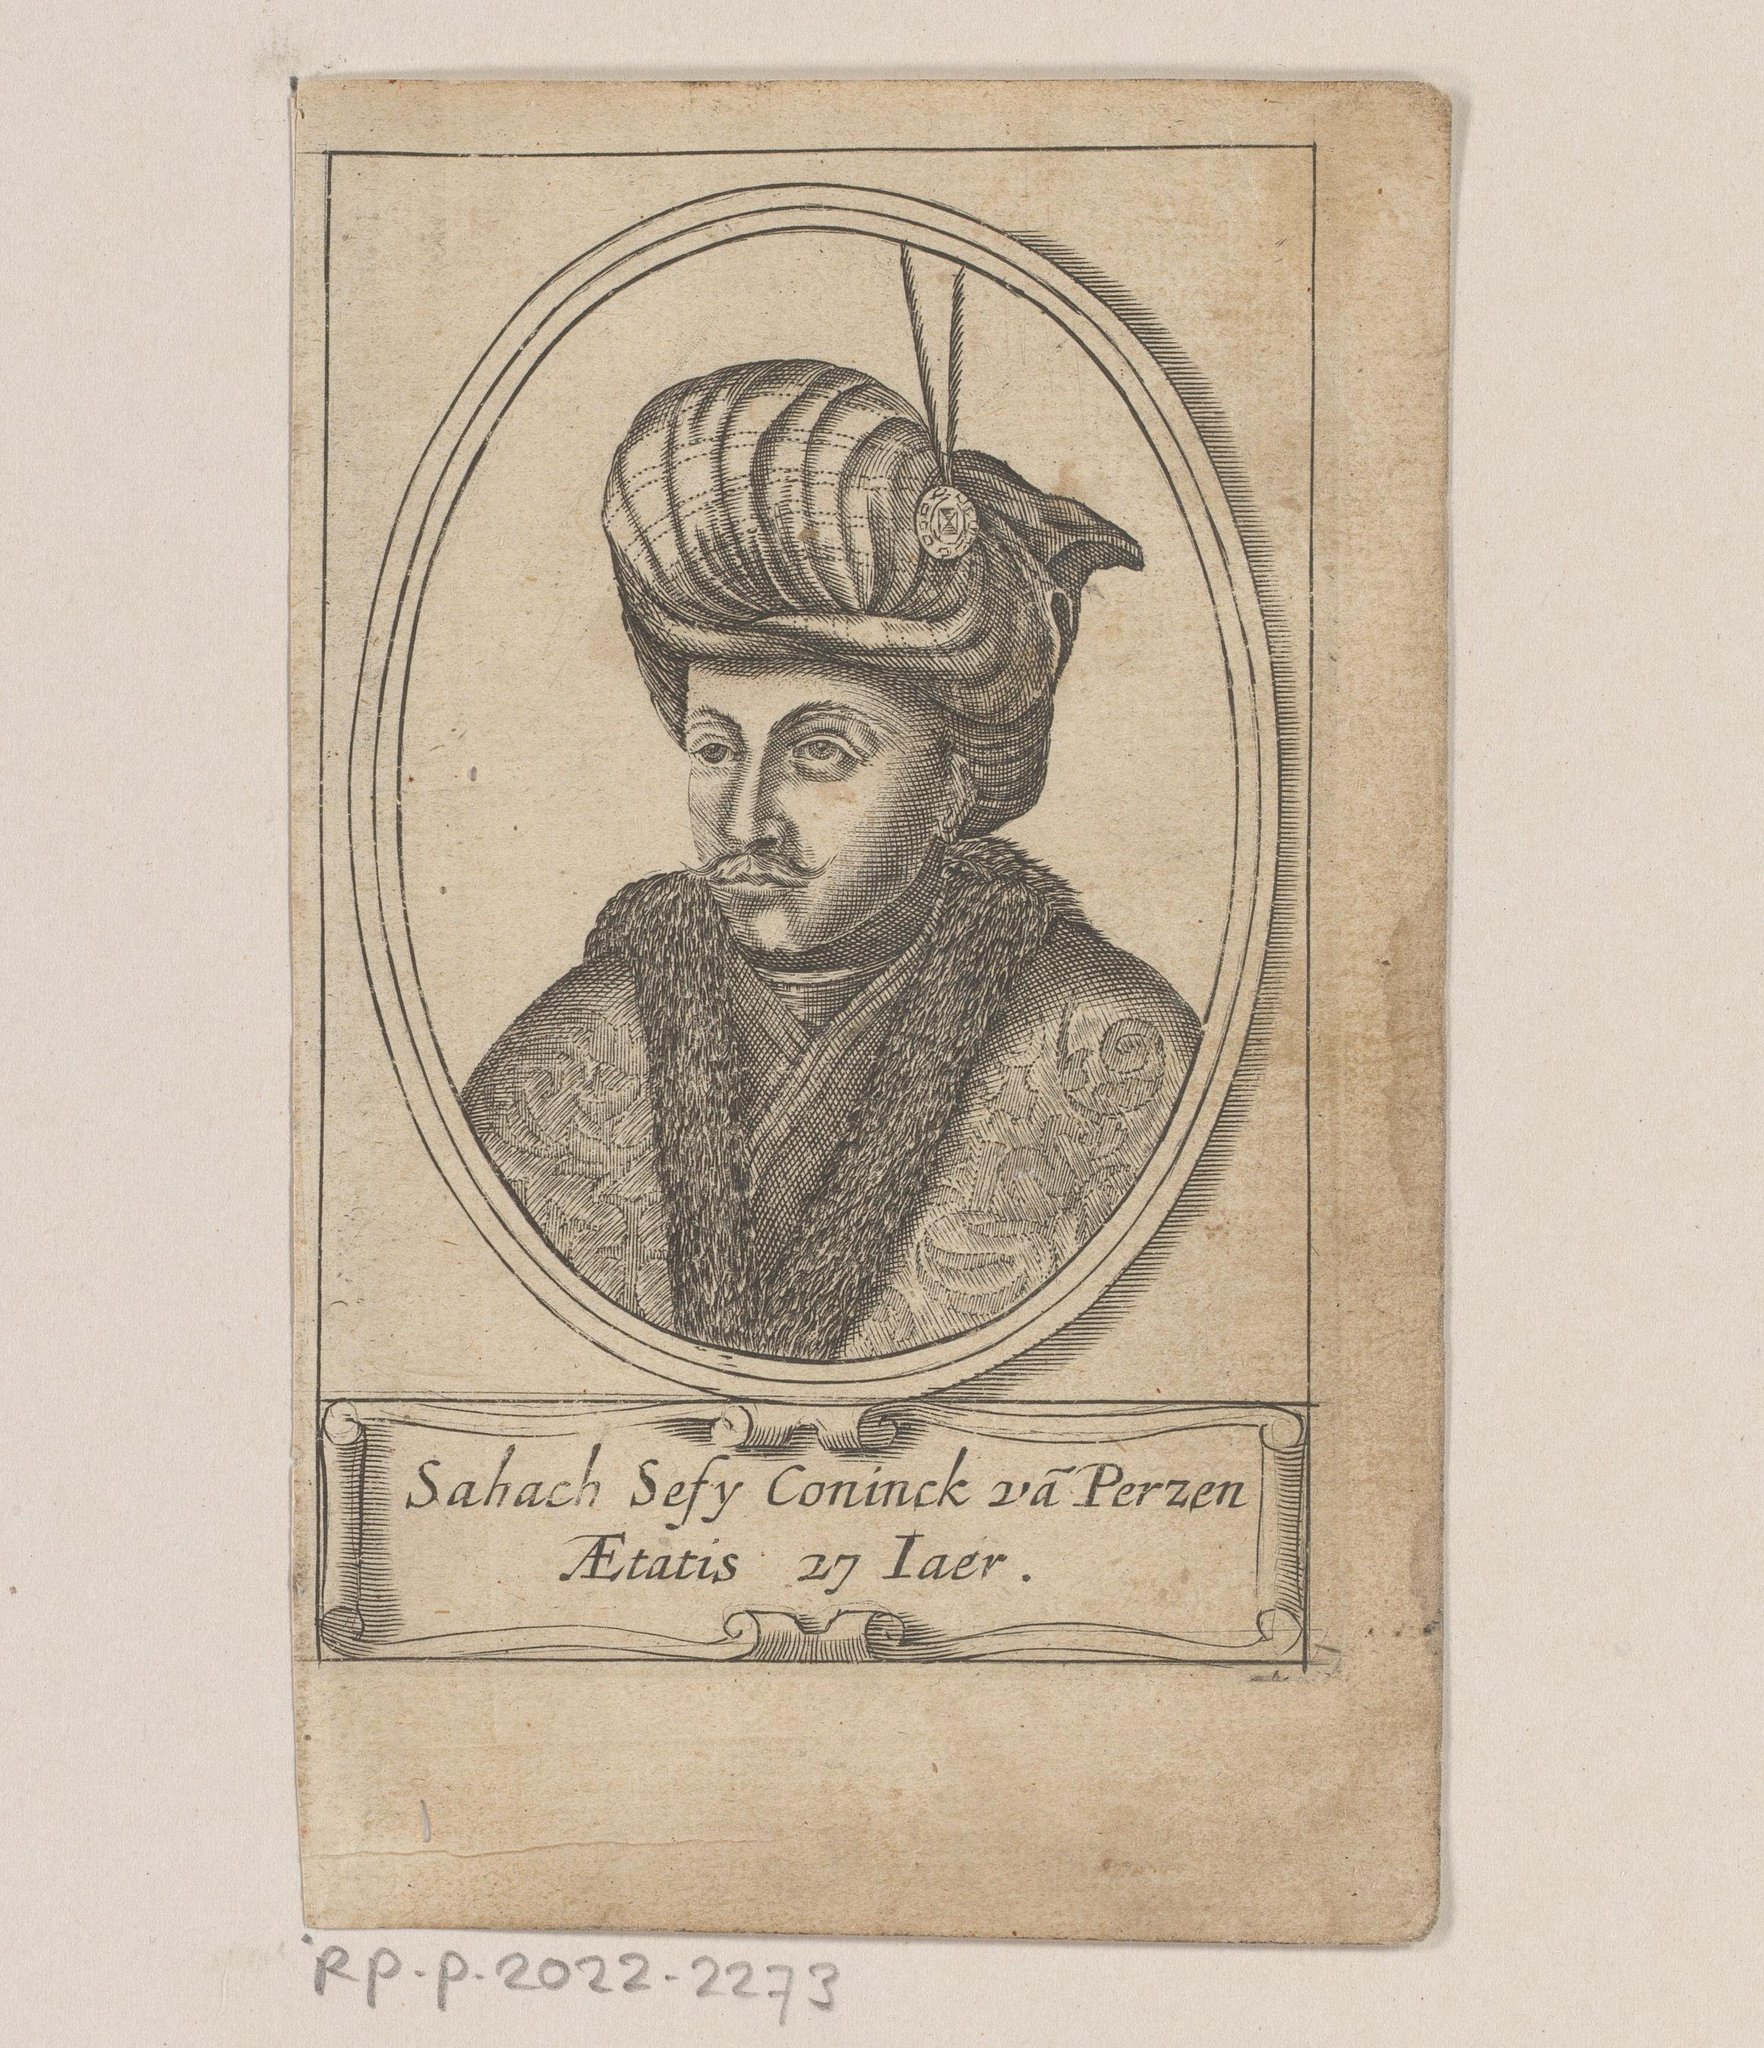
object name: print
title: Portret van Shah Safi op 27-jarige leeftijd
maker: Anonymous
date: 1652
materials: paper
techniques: engraving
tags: other sovereign, historical persons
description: Prent waarschijnlijk uit: Olearius, Adam, Johann Albrecht von Mandelslo en Dirck van Wageningh. Beschijvingh vande nieuwe Parciaensche ofte Orientaelsche reyse (...). Amsterdam: Jacob Benjamin, 1652.